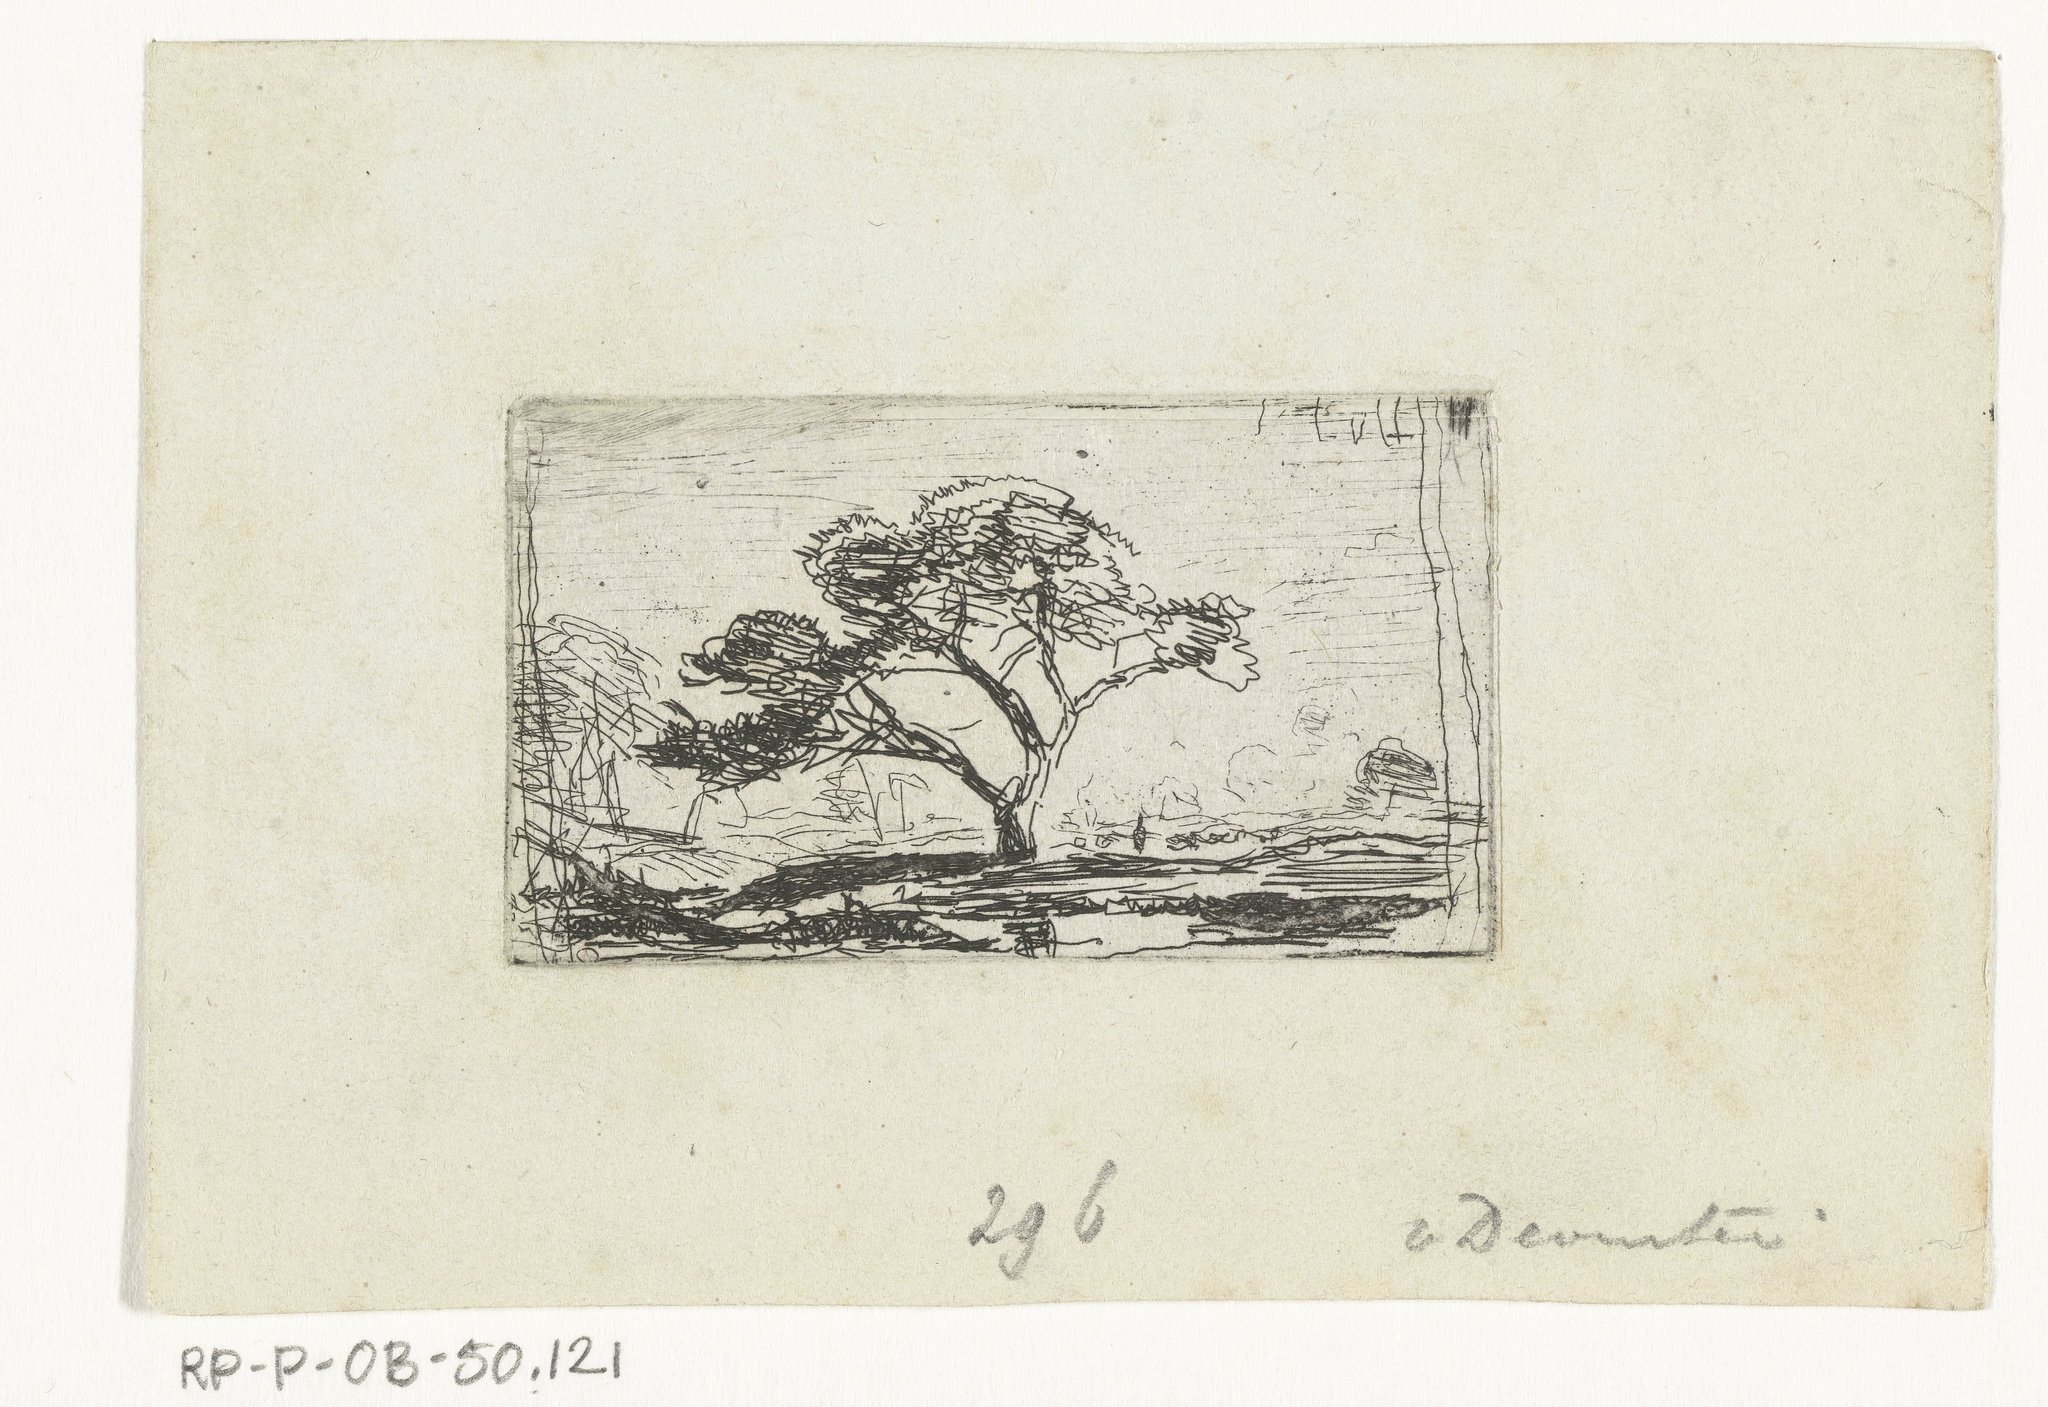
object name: print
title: Landschap met boom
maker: jan frederik van deventer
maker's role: print maker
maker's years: 1822-1886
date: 1832-1886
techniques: printmaking, etching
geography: netherlands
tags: trees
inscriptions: collector's mark: Lugt 2228